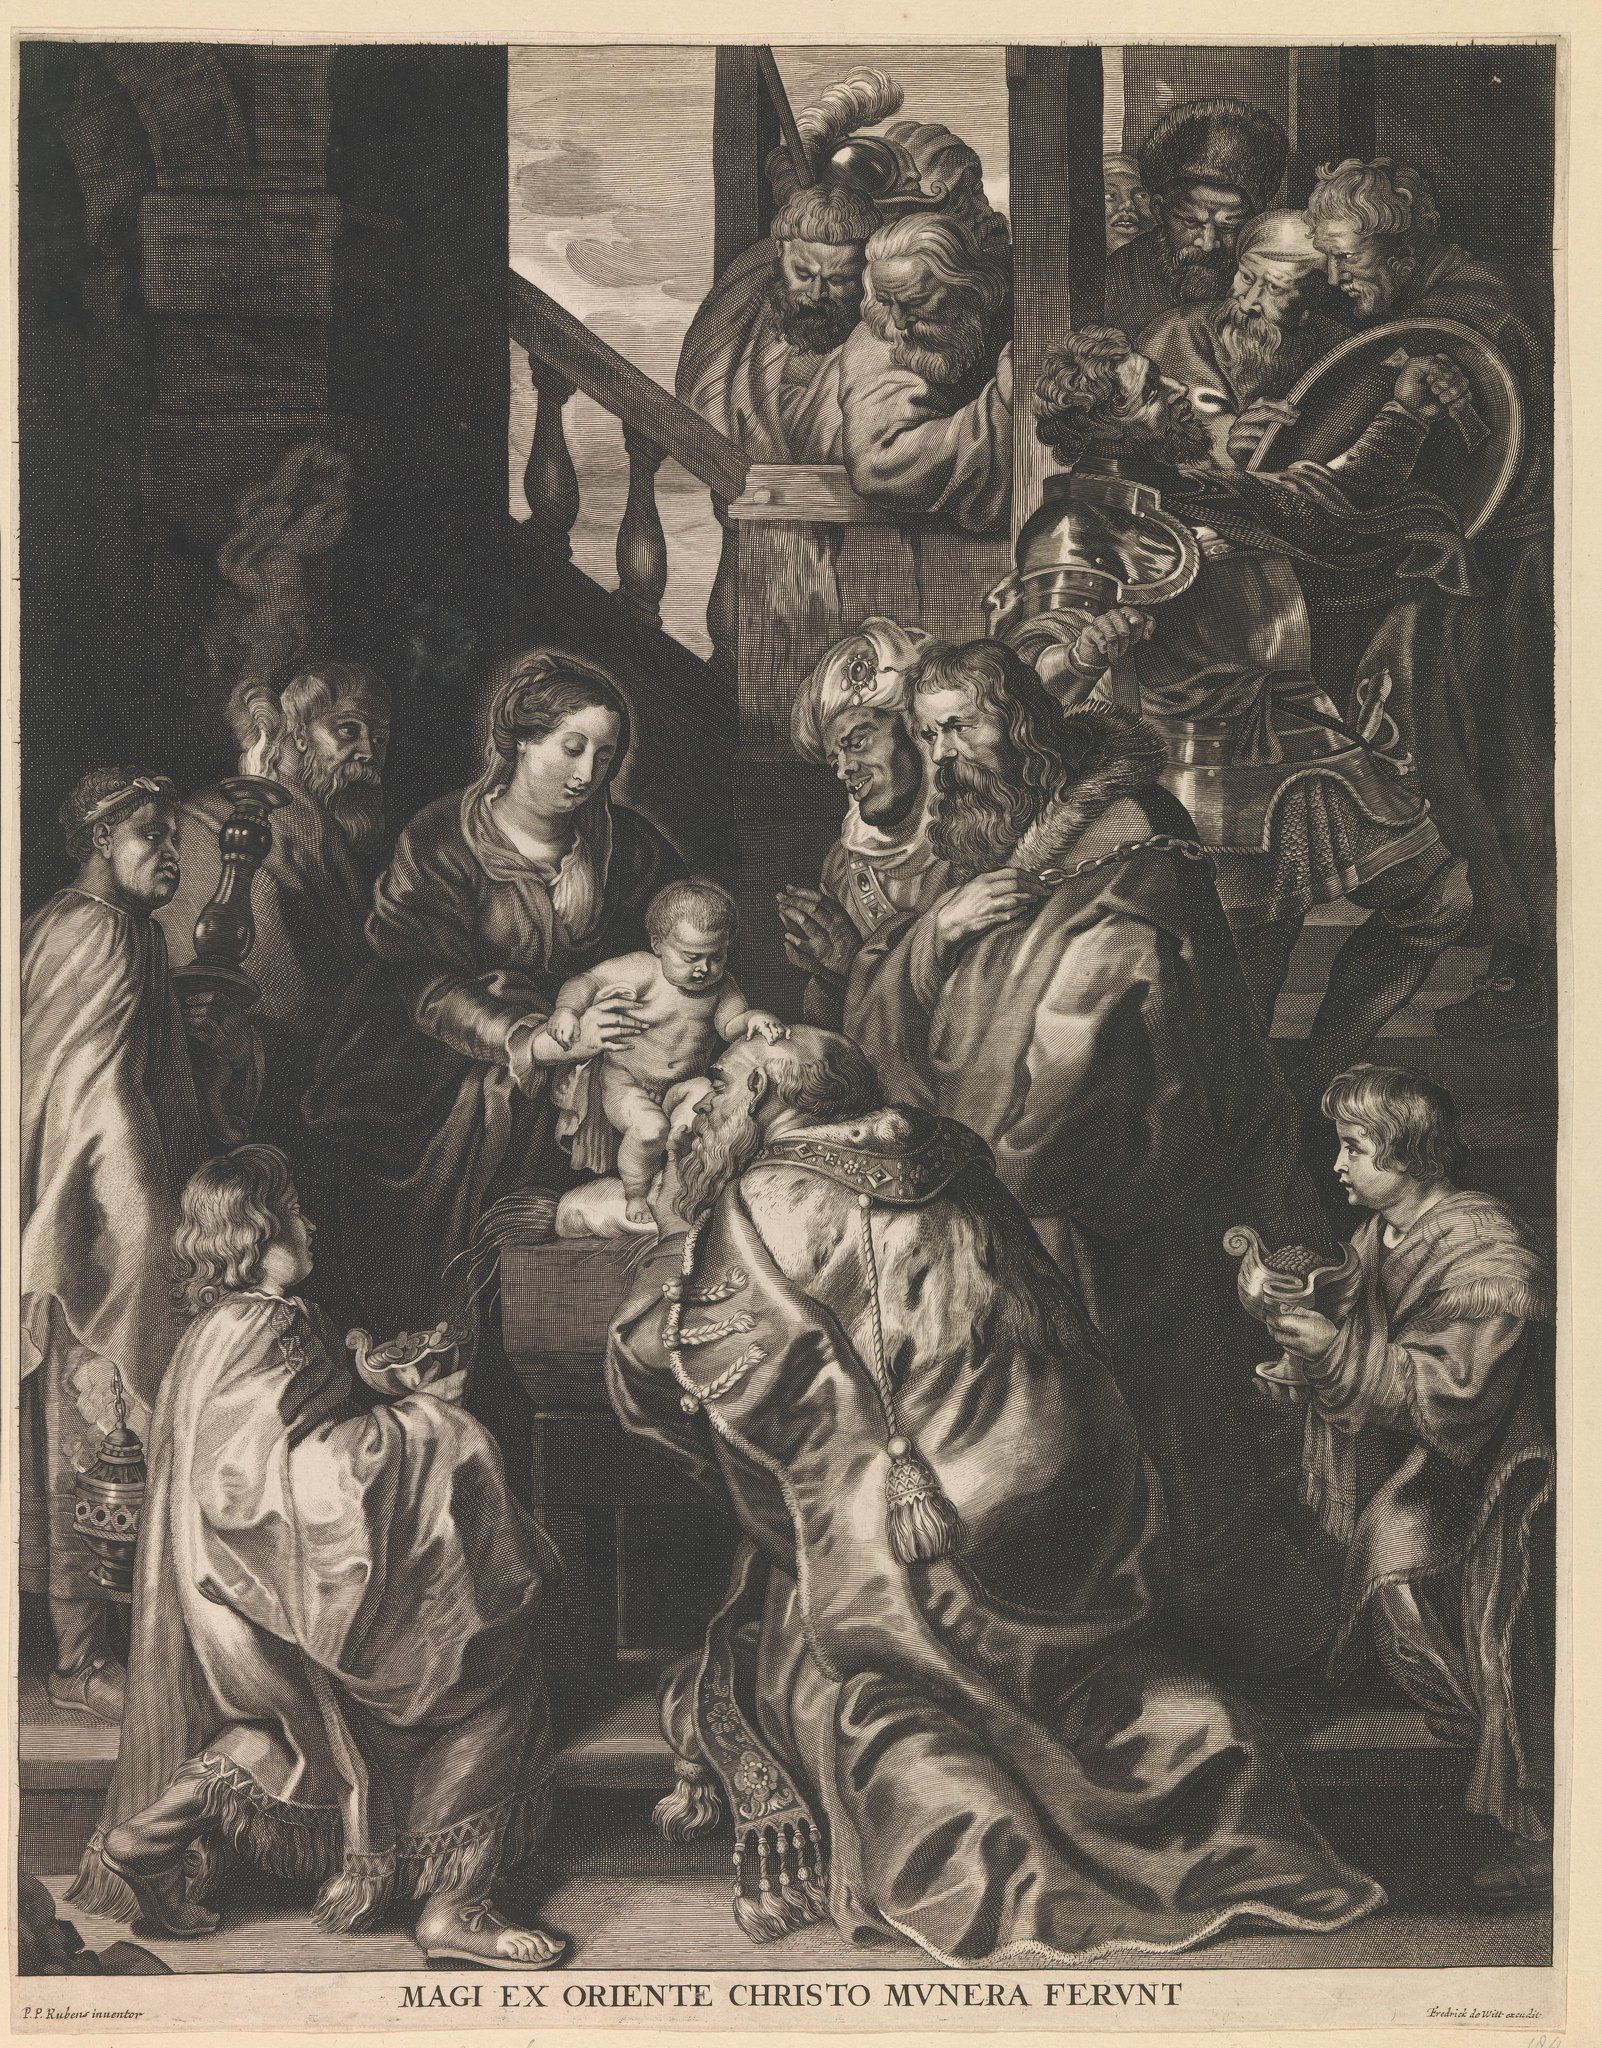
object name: print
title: Aanbidding der koningen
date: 1645-1706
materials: paper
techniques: engraving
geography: antwerp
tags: adoration of the kings: the wise men present their gifts to the christ-child (gold, frankincense and myrrh)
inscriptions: collector's mark: Lugt 240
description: Maria houdt het Christuskind vast zodat de geknielde koning zijn voet kan kussen. Op de voorgrond twee jongens met kostbare geschenken. De twee andere koningen staan rechts in aanbidding bij het Christuskind. Op de trap wordt een groep mannen tegengehouden.